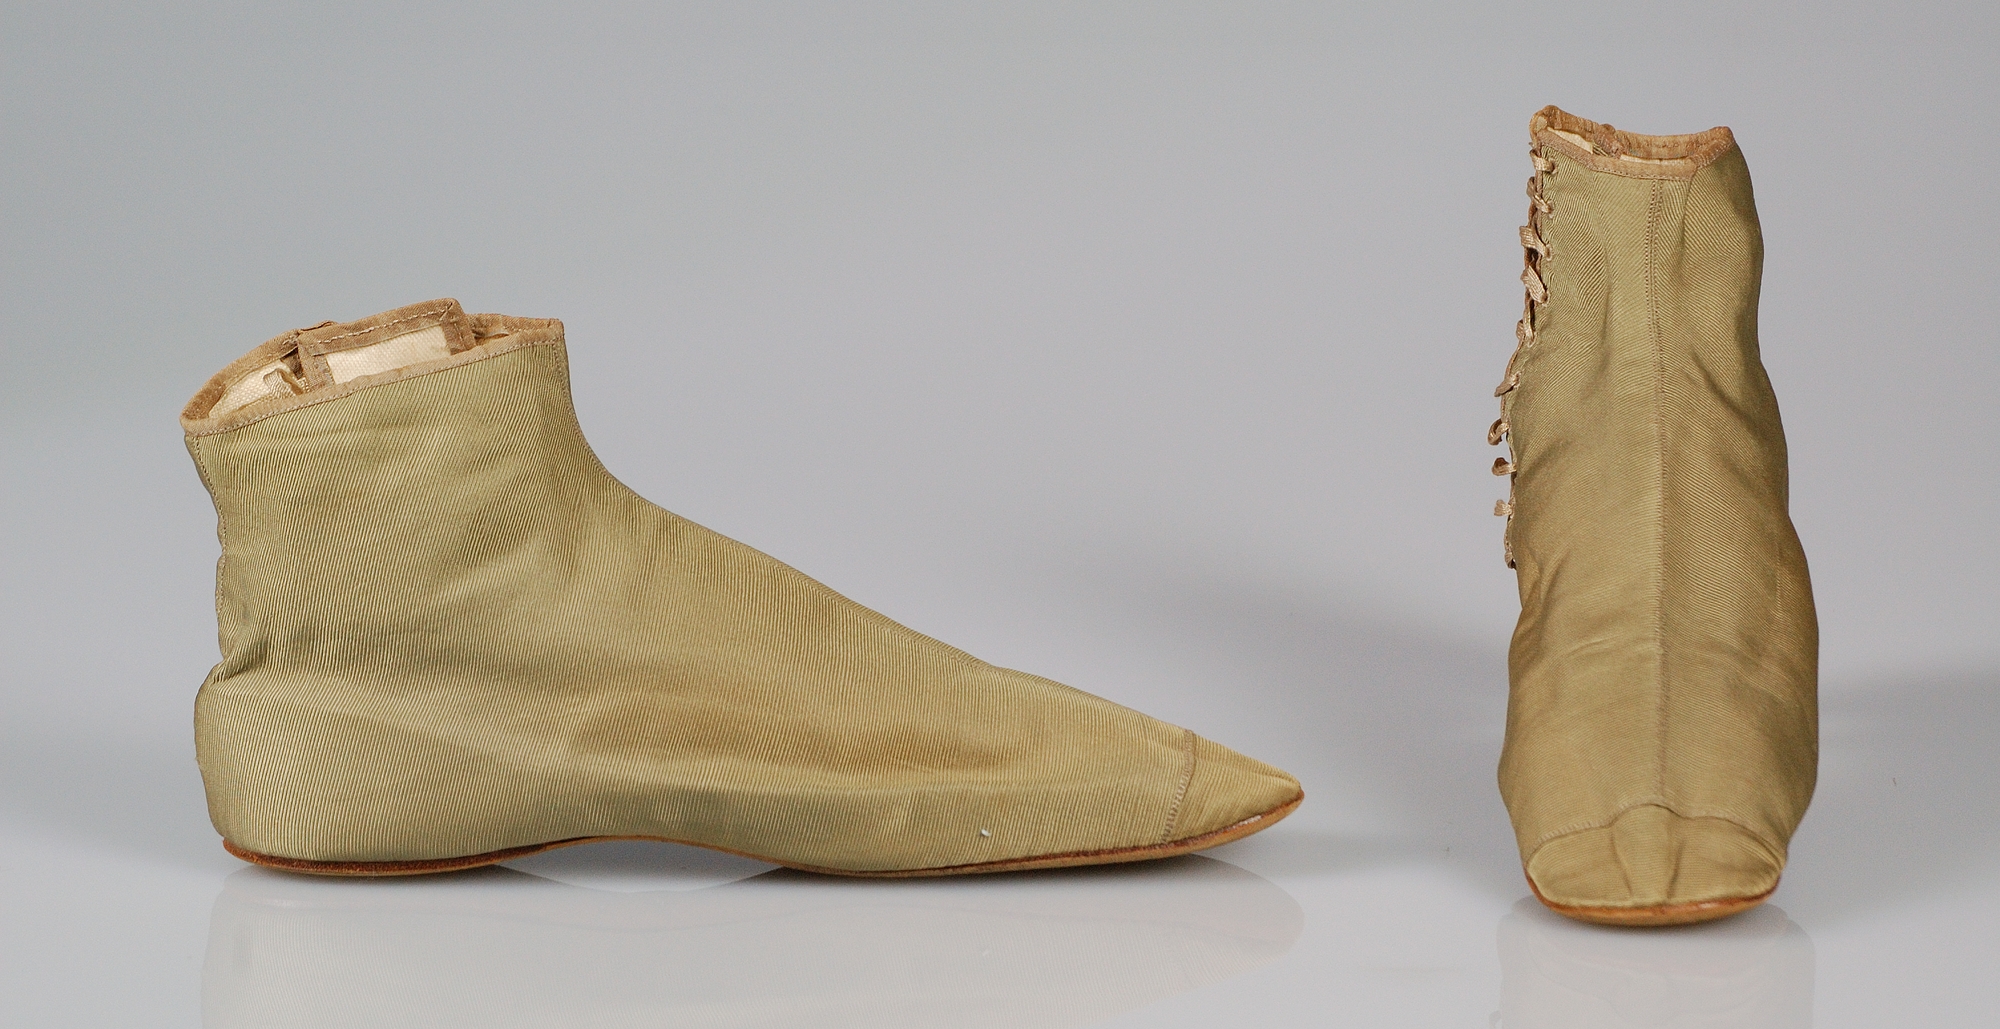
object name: boot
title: Boots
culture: american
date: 1850-1865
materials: silk